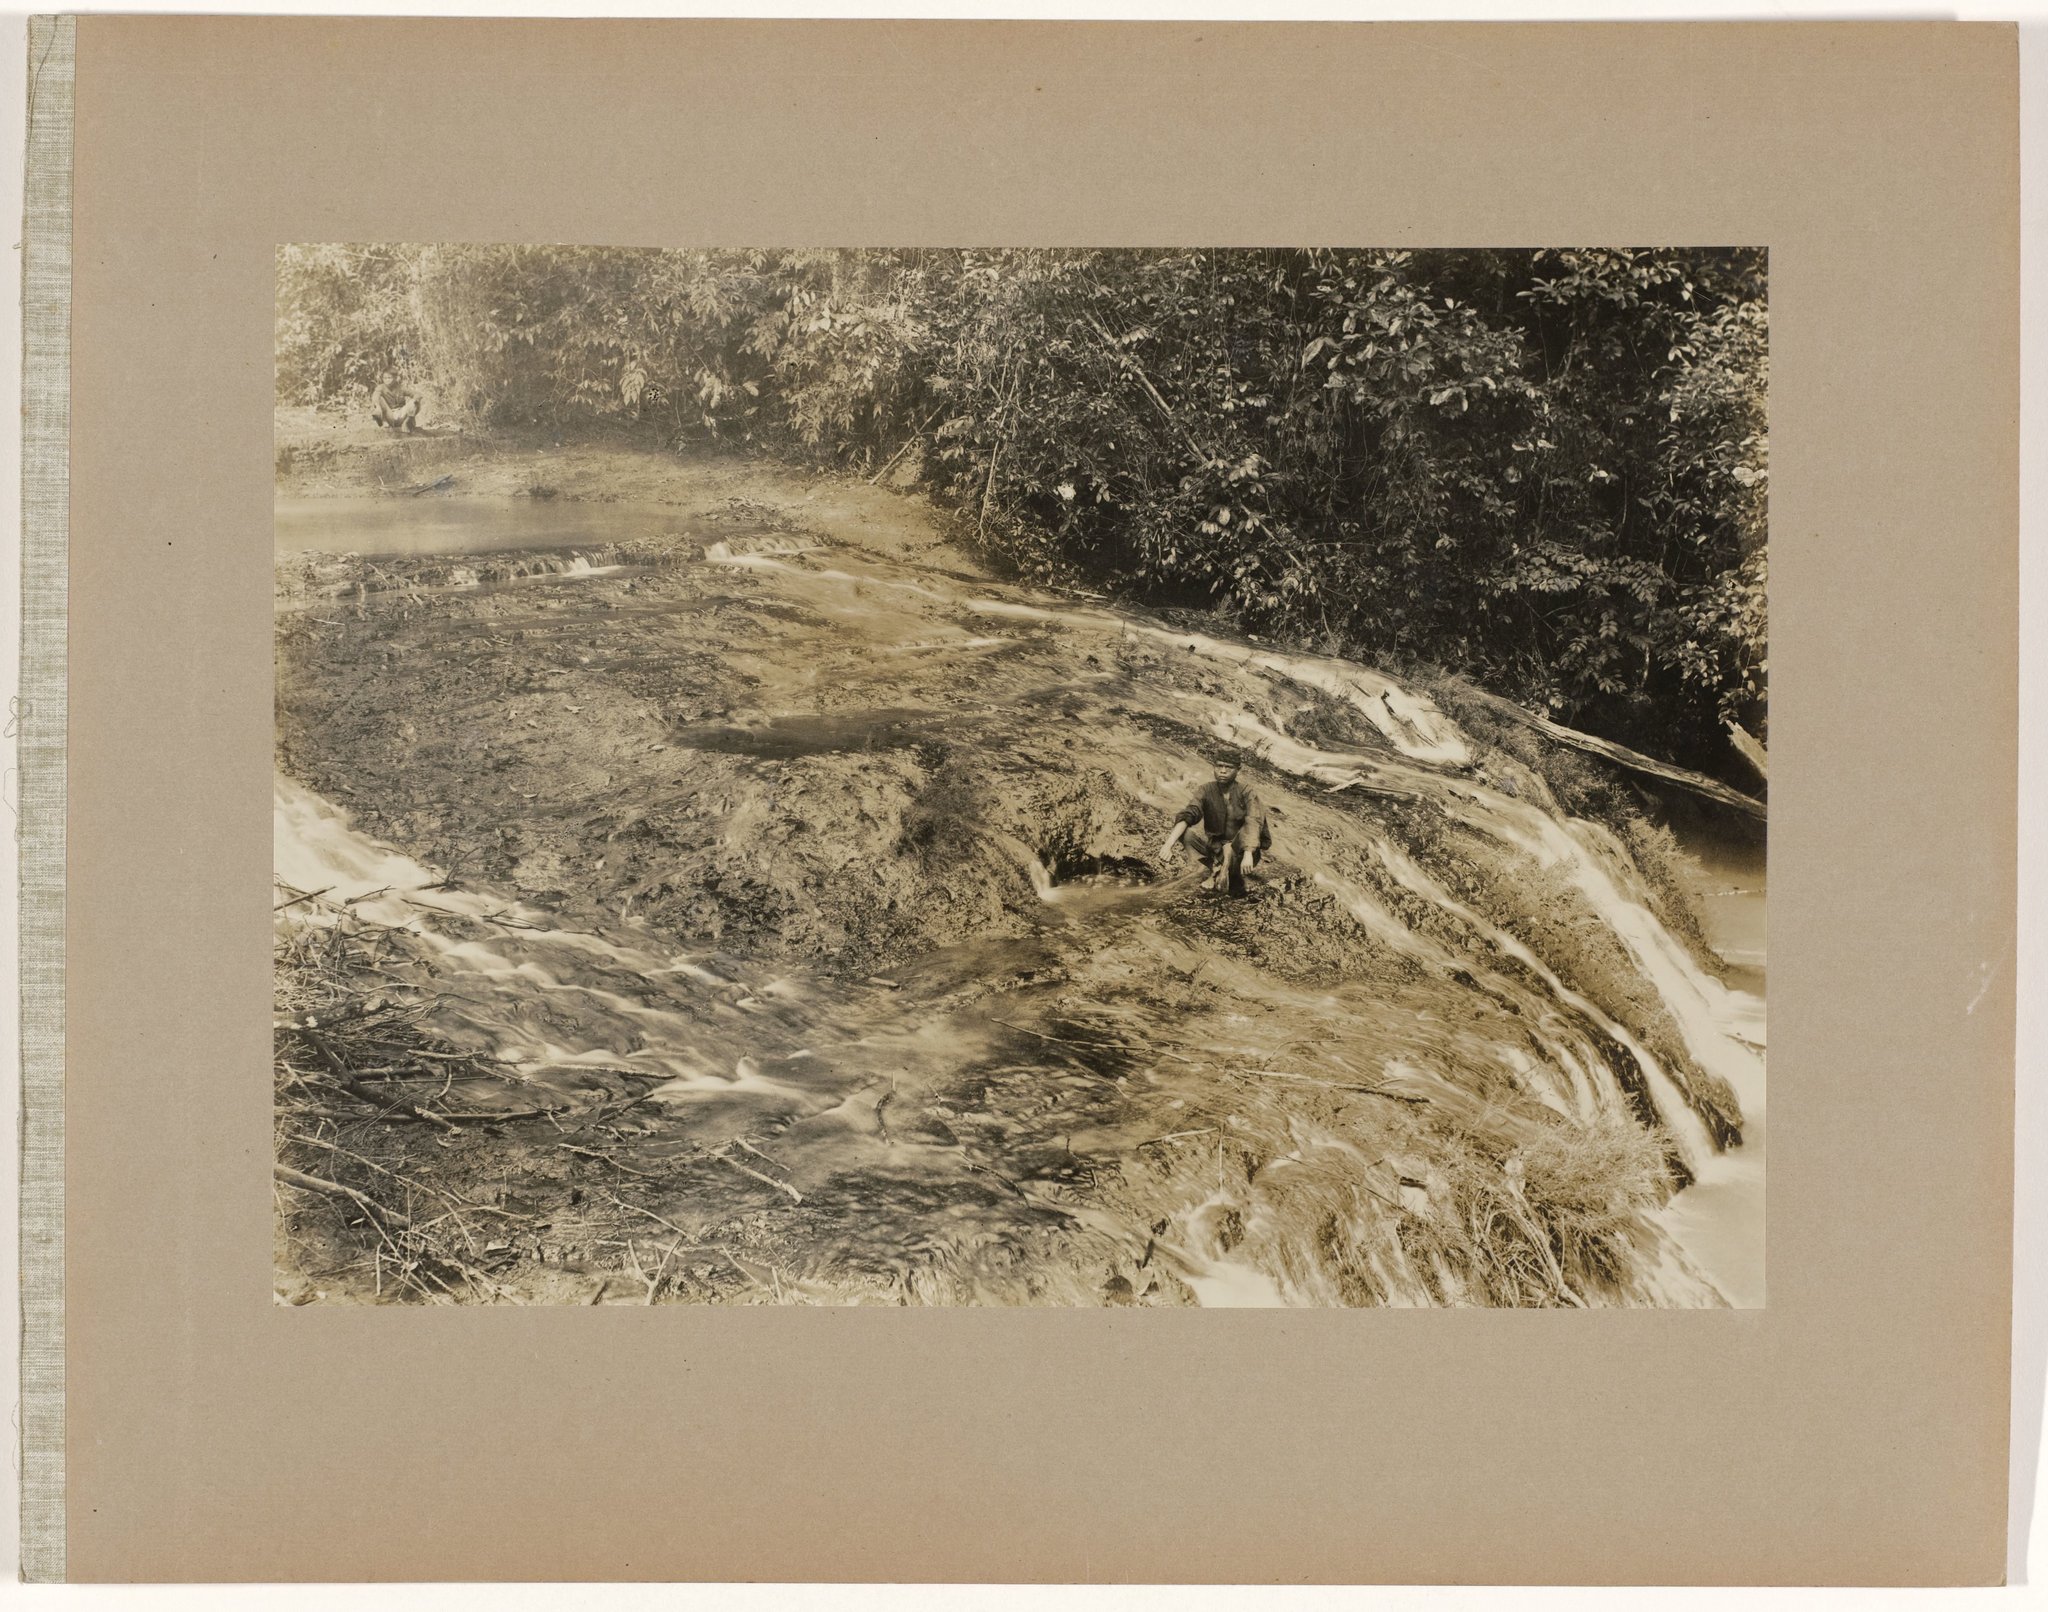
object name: photograph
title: Waterval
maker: Anonymous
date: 1921-1922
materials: photographic support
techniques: gelatin silver print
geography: bukit asam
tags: colonial system, waterfall, sumatra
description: Een waterval in een bos, op de rotsen zitten twee inlandse mannen. Onderdeel van het losbladige fotoalbum aangeboden door het personeel van de Boekit-Asam Steenkolenmijnen op Sumatra aan de scheidende Ingenieur-Directeur H. Tromp op 7 januari 1922.